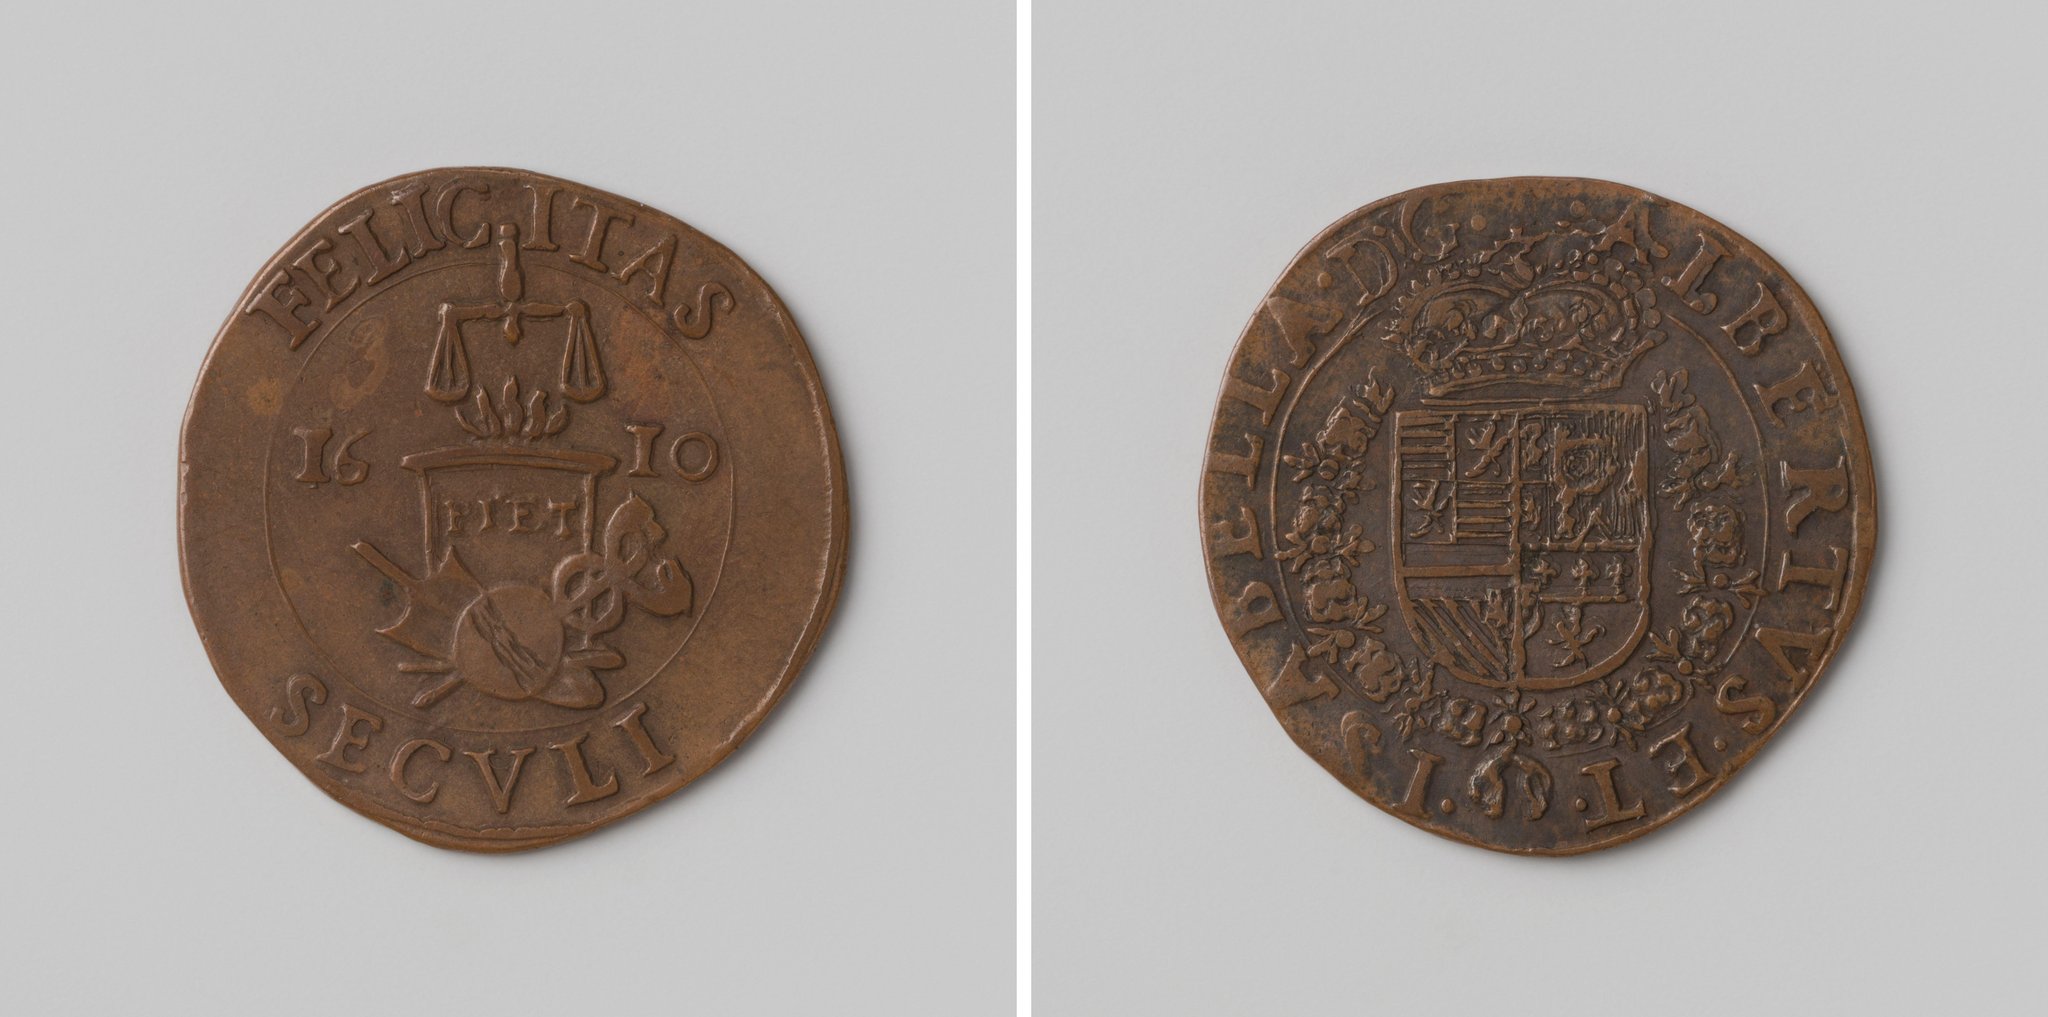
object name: jeton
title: Gelukkige bestuur van Albrecht en Isabella van Oostenrijk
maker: Anonymous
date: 1610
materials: copper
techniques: striking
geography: belgium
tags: infante van spanje isabella clara eugenia, brussels, albrecht aartshertog van oostenrijk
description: Koperen penning. Voorzijde: scheepsroer, wereldbol en Mercuriusstaf, liggend aan voet van brandend altaar, waarboven weegschaal in evenwicht hangt tussen jaartal binnen omschrift. Keerzijde: gekroond wapenschild, omhangen met de orde van het Gulden Vlies binnen omschrift